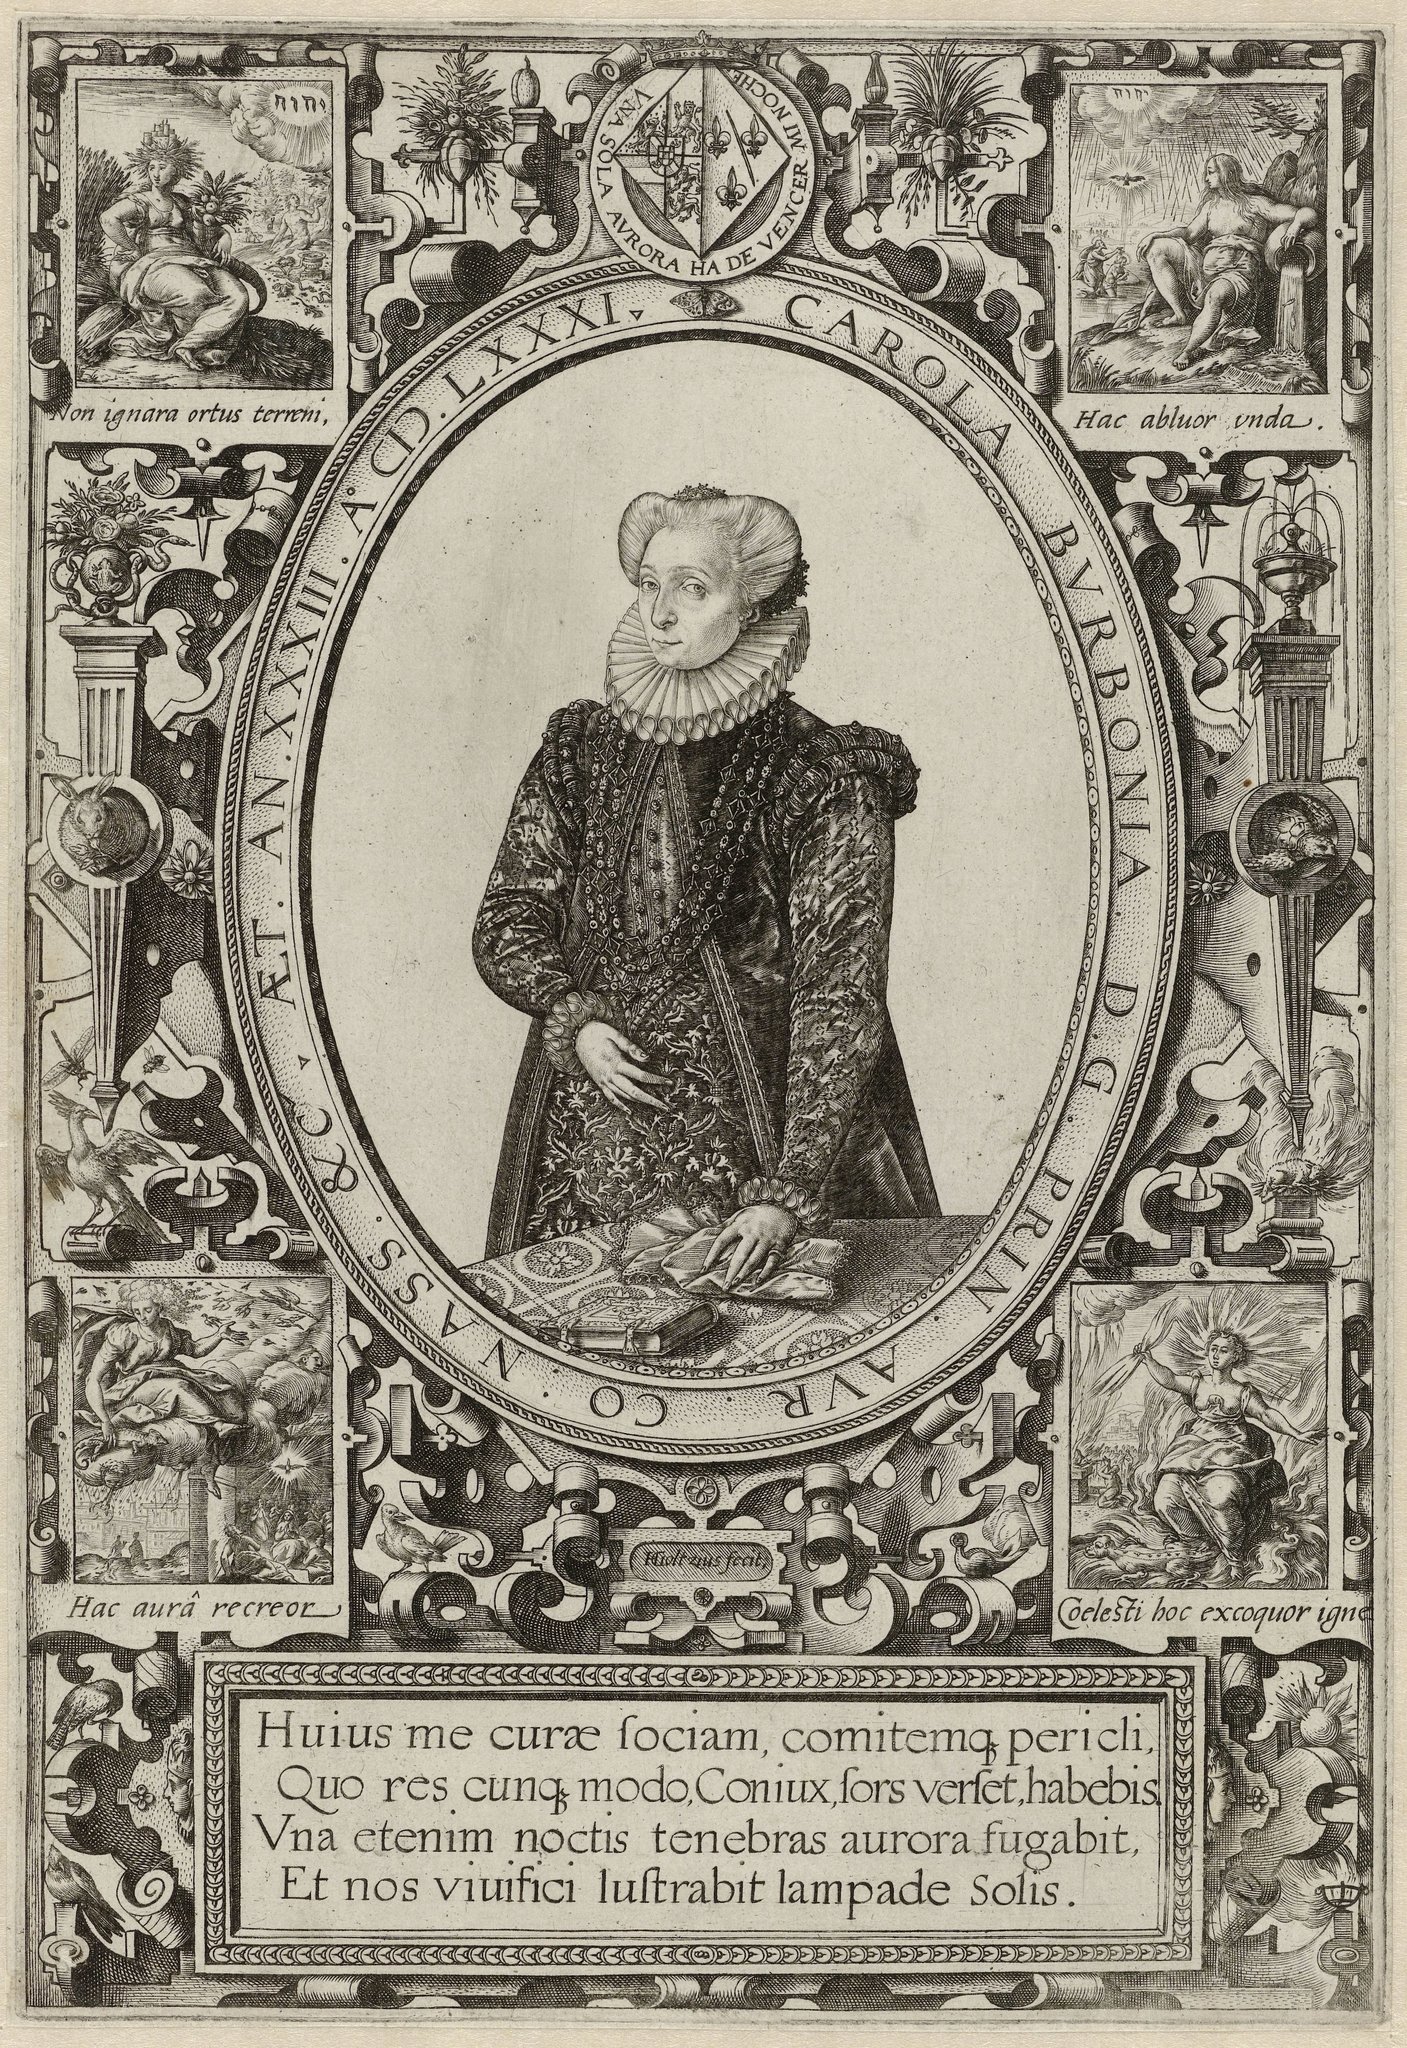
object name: print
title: Portret van Charlotte de Bourbon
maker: hendrick goltzius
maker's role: draughtsman, painter, print maker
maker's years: 1558-1617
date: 1581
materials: paper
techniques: engraving, etching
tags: antwerp, charlotte of bourbon, handkerchief (+ women's clothes), head-gear (with name), historical persons - bb - woman, dress, gown (vlieger) (+ women's clothes), styles of hairdress - aa - ~ women, neck-gear ~ clothing (with name) (+ women's clothes), gloves, mittens, etc. (+ women's clothes), necklace (+ women's clothes)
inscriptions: mark: ‘L.963.’, mark: ‘L. 2228a’, edge inscription: ‘CAROLA BVRBONIA. D.G. PRIN.AVR.CO:NASS.&C. AET.AN.XXXIII.A CD.LXXXI’, signature: ‘HGoltzius fecit’, caption: ‘Huius me curae../.../...lustrabit lampade Solis.’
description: Kleding: vlieger* zonder mouwen, dubbele schouderrollen* met knopversiering. Een lijfje* met lange mouwen, geplooide kraag* en dito manchetten*. Op het opgekuifde kapsel* een vleugelmutsje*. Ihle p. 20, nr. 51: zij draagt het Spaanse kostuum, maar dan aangepast aan de Franse smaak, die ook de Nederlandse mode heeft beinvloed. In tegenstelling tot de Spaanse haardracht, die tot een steeds hogere kuif werd opgemaakt, is hier het haar boven de slapen tot twee vleugels opgemaakt, terwijl de rest door een kostbaar kapje bijeengehouden wordt. Plooikraag en 'vlieger', een aan de hals alleen gesloten wijd uitstaand overkleed met schouderwrongen aan de schouders.